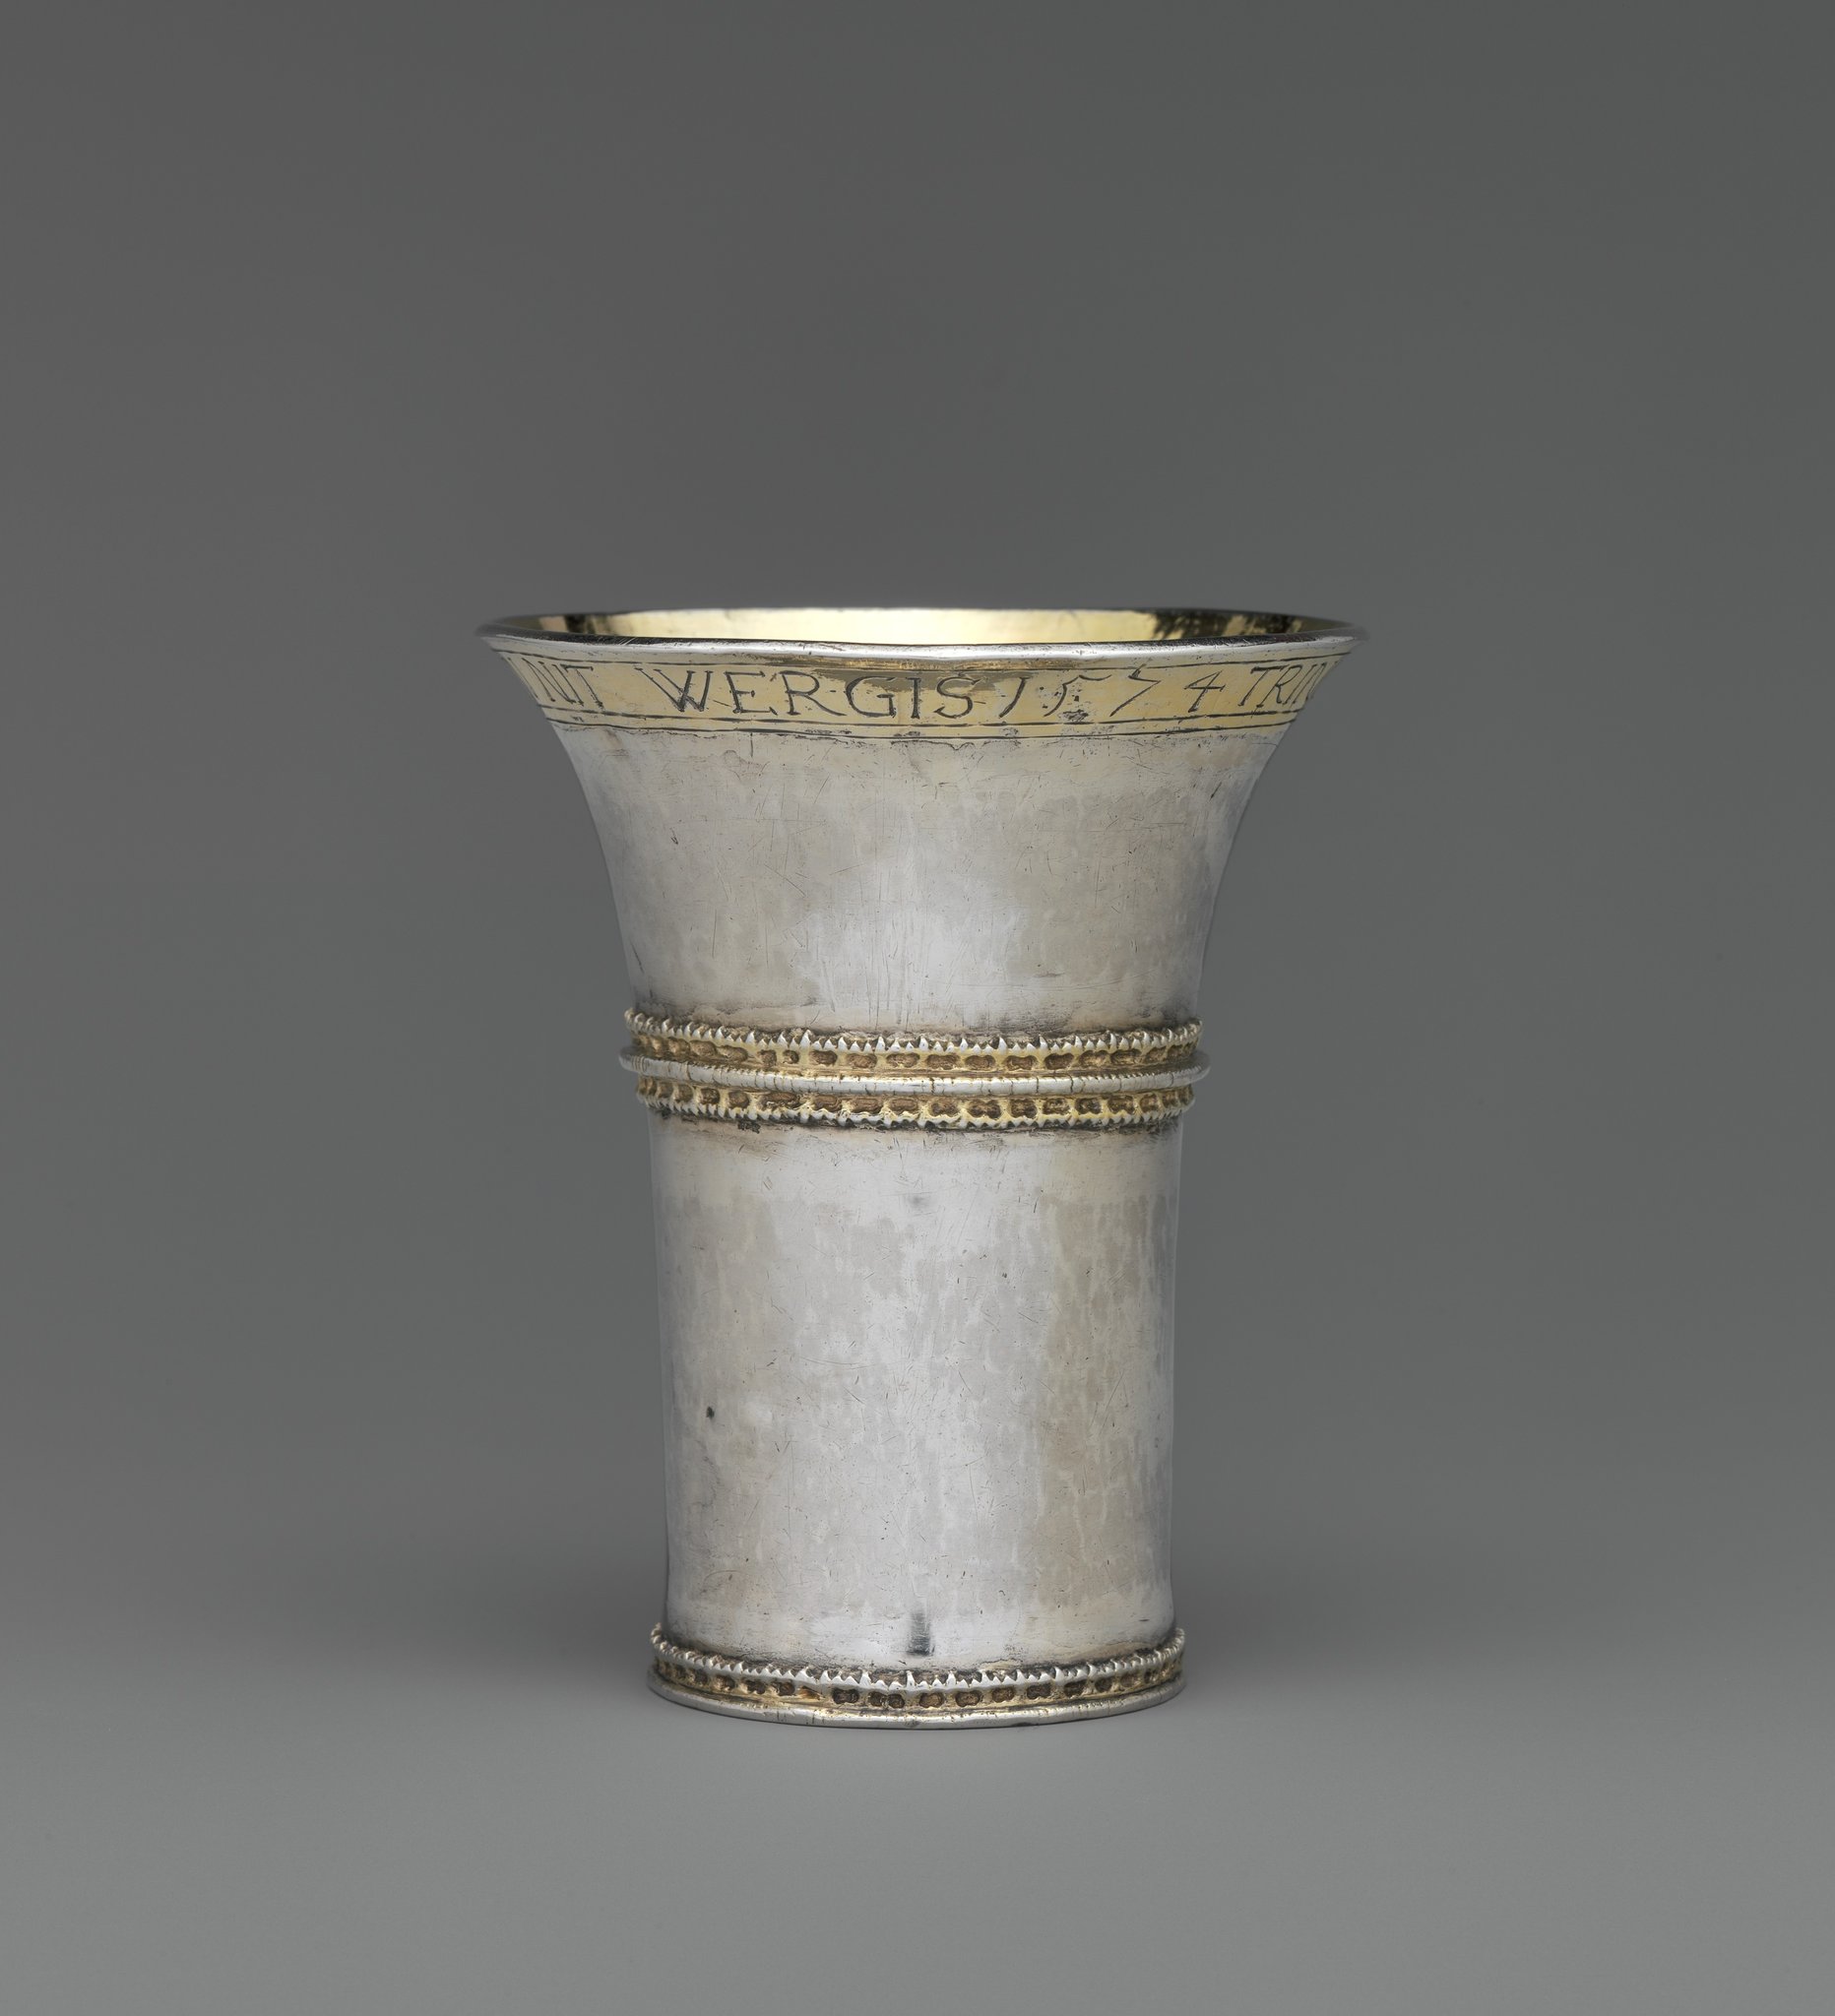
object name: beaker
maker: valentinus (felten) dengel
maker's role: maker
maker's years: 1550-1570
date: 1574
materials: silver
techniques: gilding